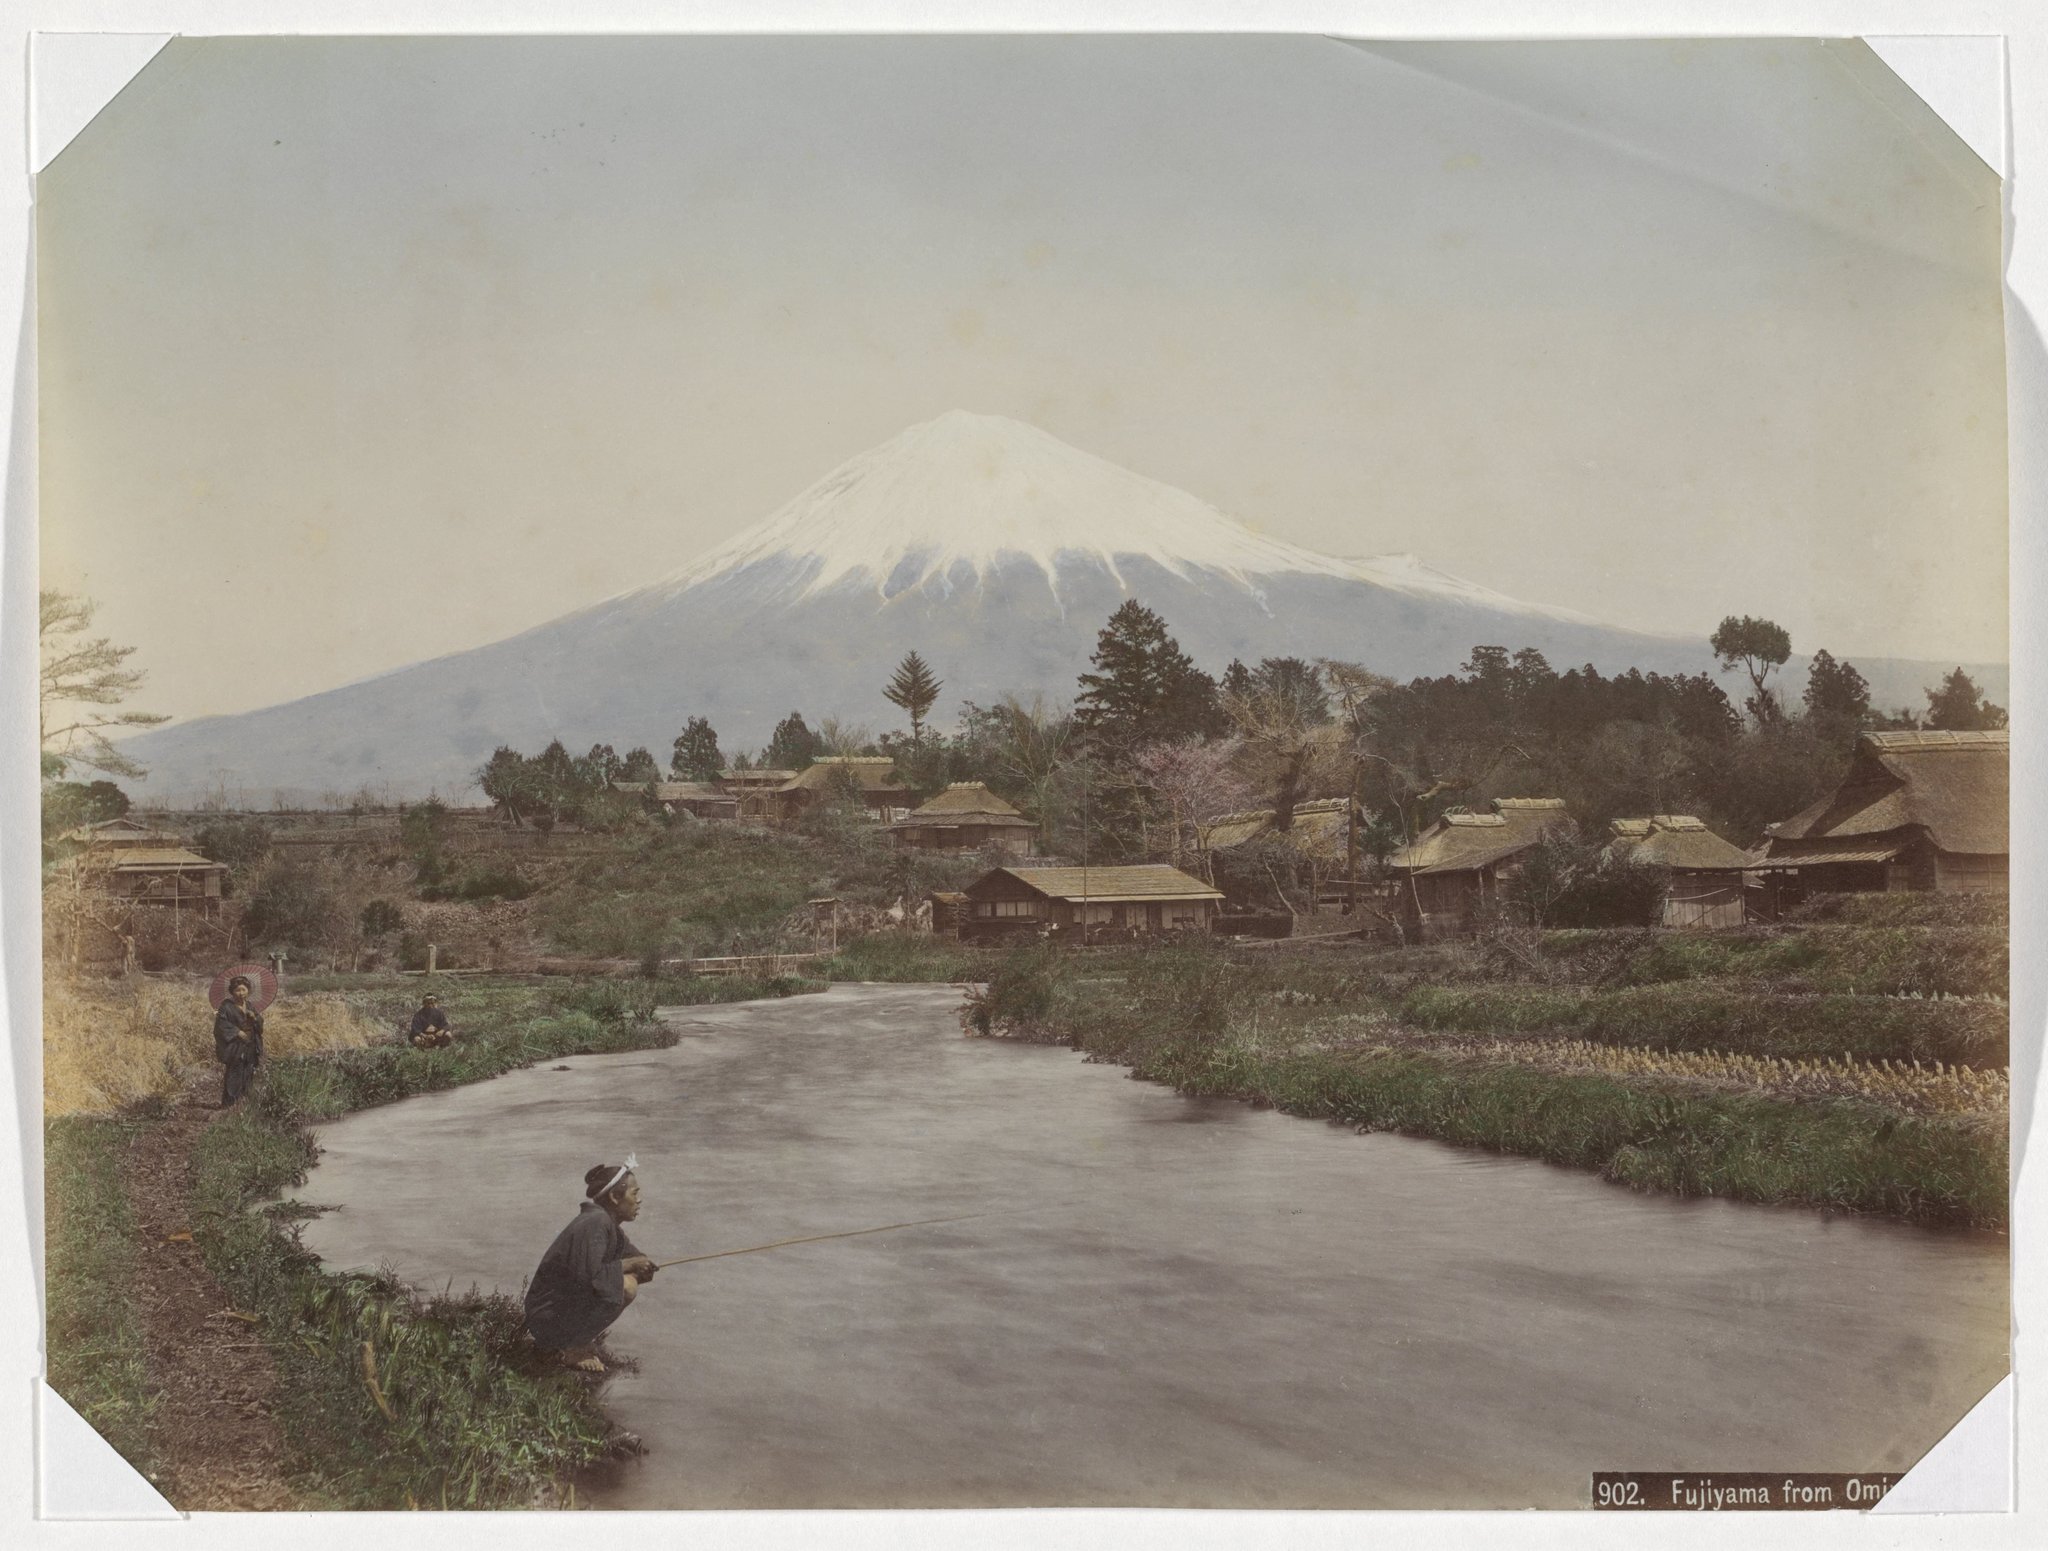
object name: photograph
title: Fujiyama from Omiya Village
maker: kusakabe kimbei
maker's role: fotograaf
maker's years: 1841-1934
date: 1890-1894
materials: cardboard, paper, photographic support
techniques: albumen print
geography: japan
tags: mountain-top, peak (+ landscape with figures, staffage)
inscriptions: negative number: ‘902’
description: Onderdeel van Album met 69 foto's van een reis door Japan.